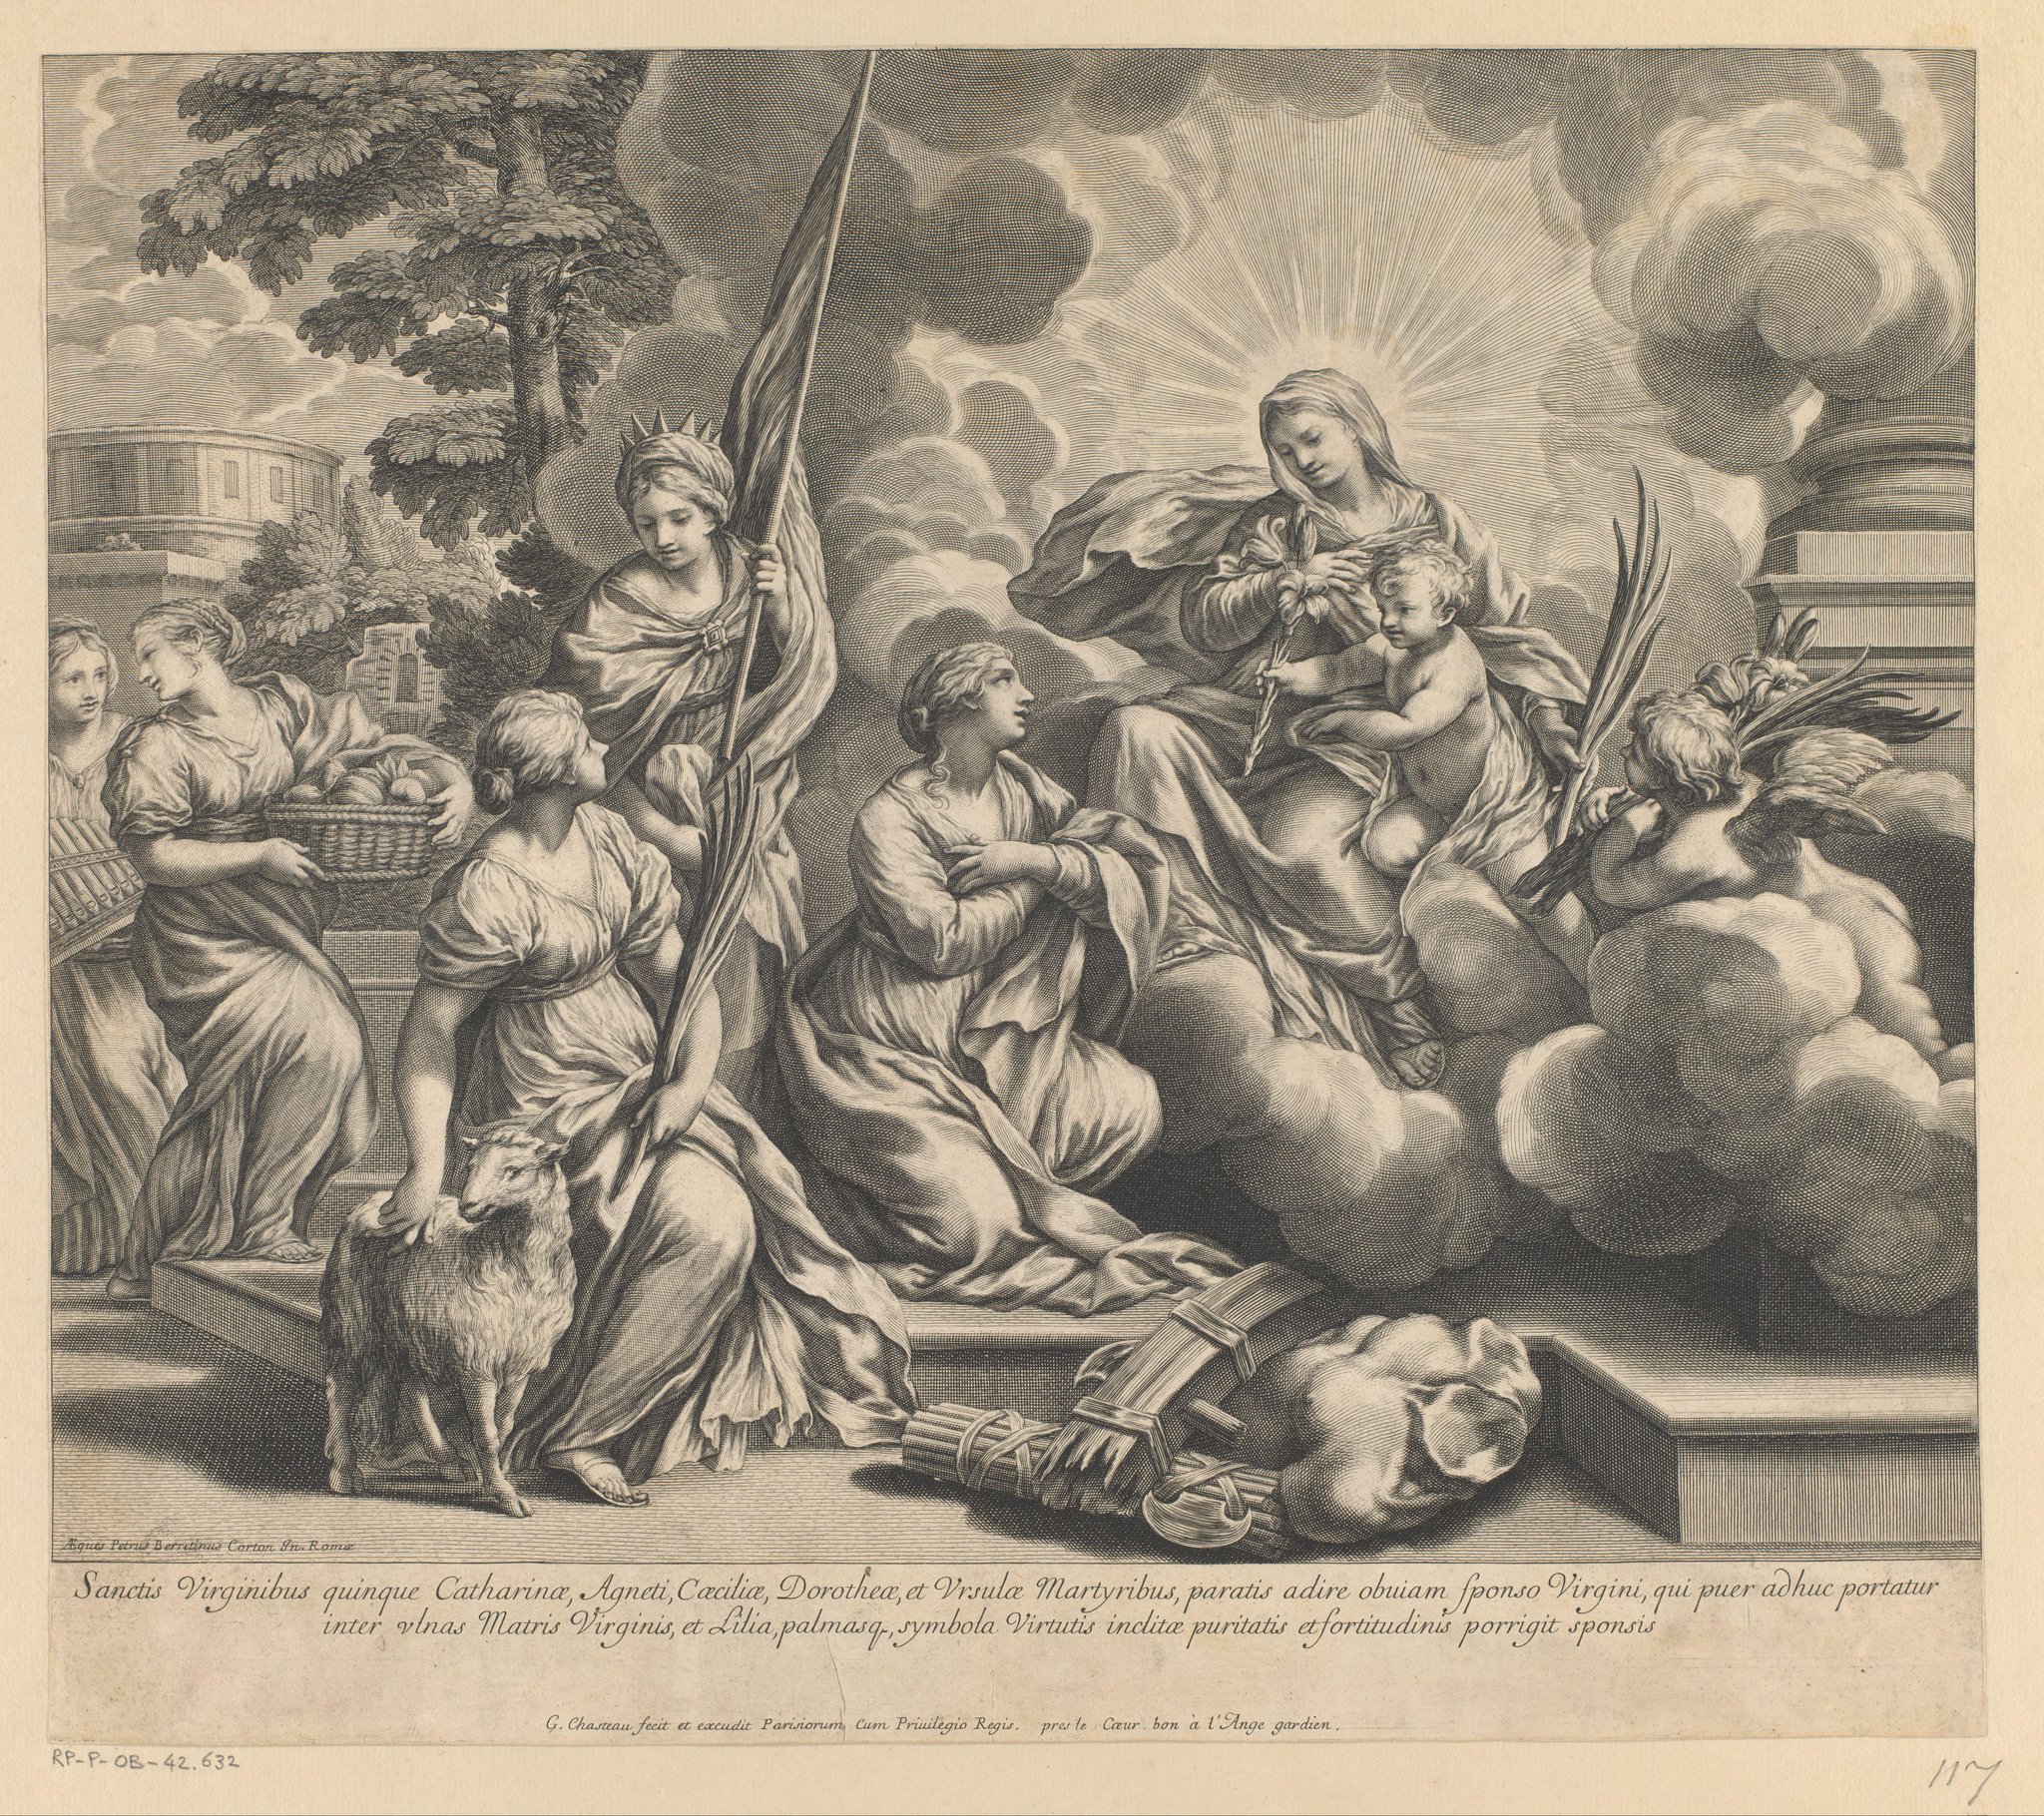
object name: print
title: Maria en Kind overhandigen lelies en palmbladeren aan H. Catharina, H. Agnes, H. Ursula, H. Dorothea en H. Cecilia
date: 1661-1683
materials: paper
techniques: engraving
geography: paris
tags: the virgin martyr ursula of cologne; possible attributes: arrow, banner with red cross, cloak of ermine, crown, ship, the virgin martyr cecilia of rome; possible attributes: falcon, musical instruments, organ, wreath of roses and lilies, the virgin martyr catherine of alexandria; possible attributes: book, crown, emperor maxentius, palm-branch, ring, sword, wheel, 'virgo inter virgines', the virgin martyr agnes of rome; possible attributes: lamb, ring, the virgin martyr dorothea of caesarea; possible attributes: basket of roses and apples, child with basket of roses, garland of roses, roses in hand or lap, madonna accompanied by saint(s)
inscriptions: collector's mark: Lugt 240